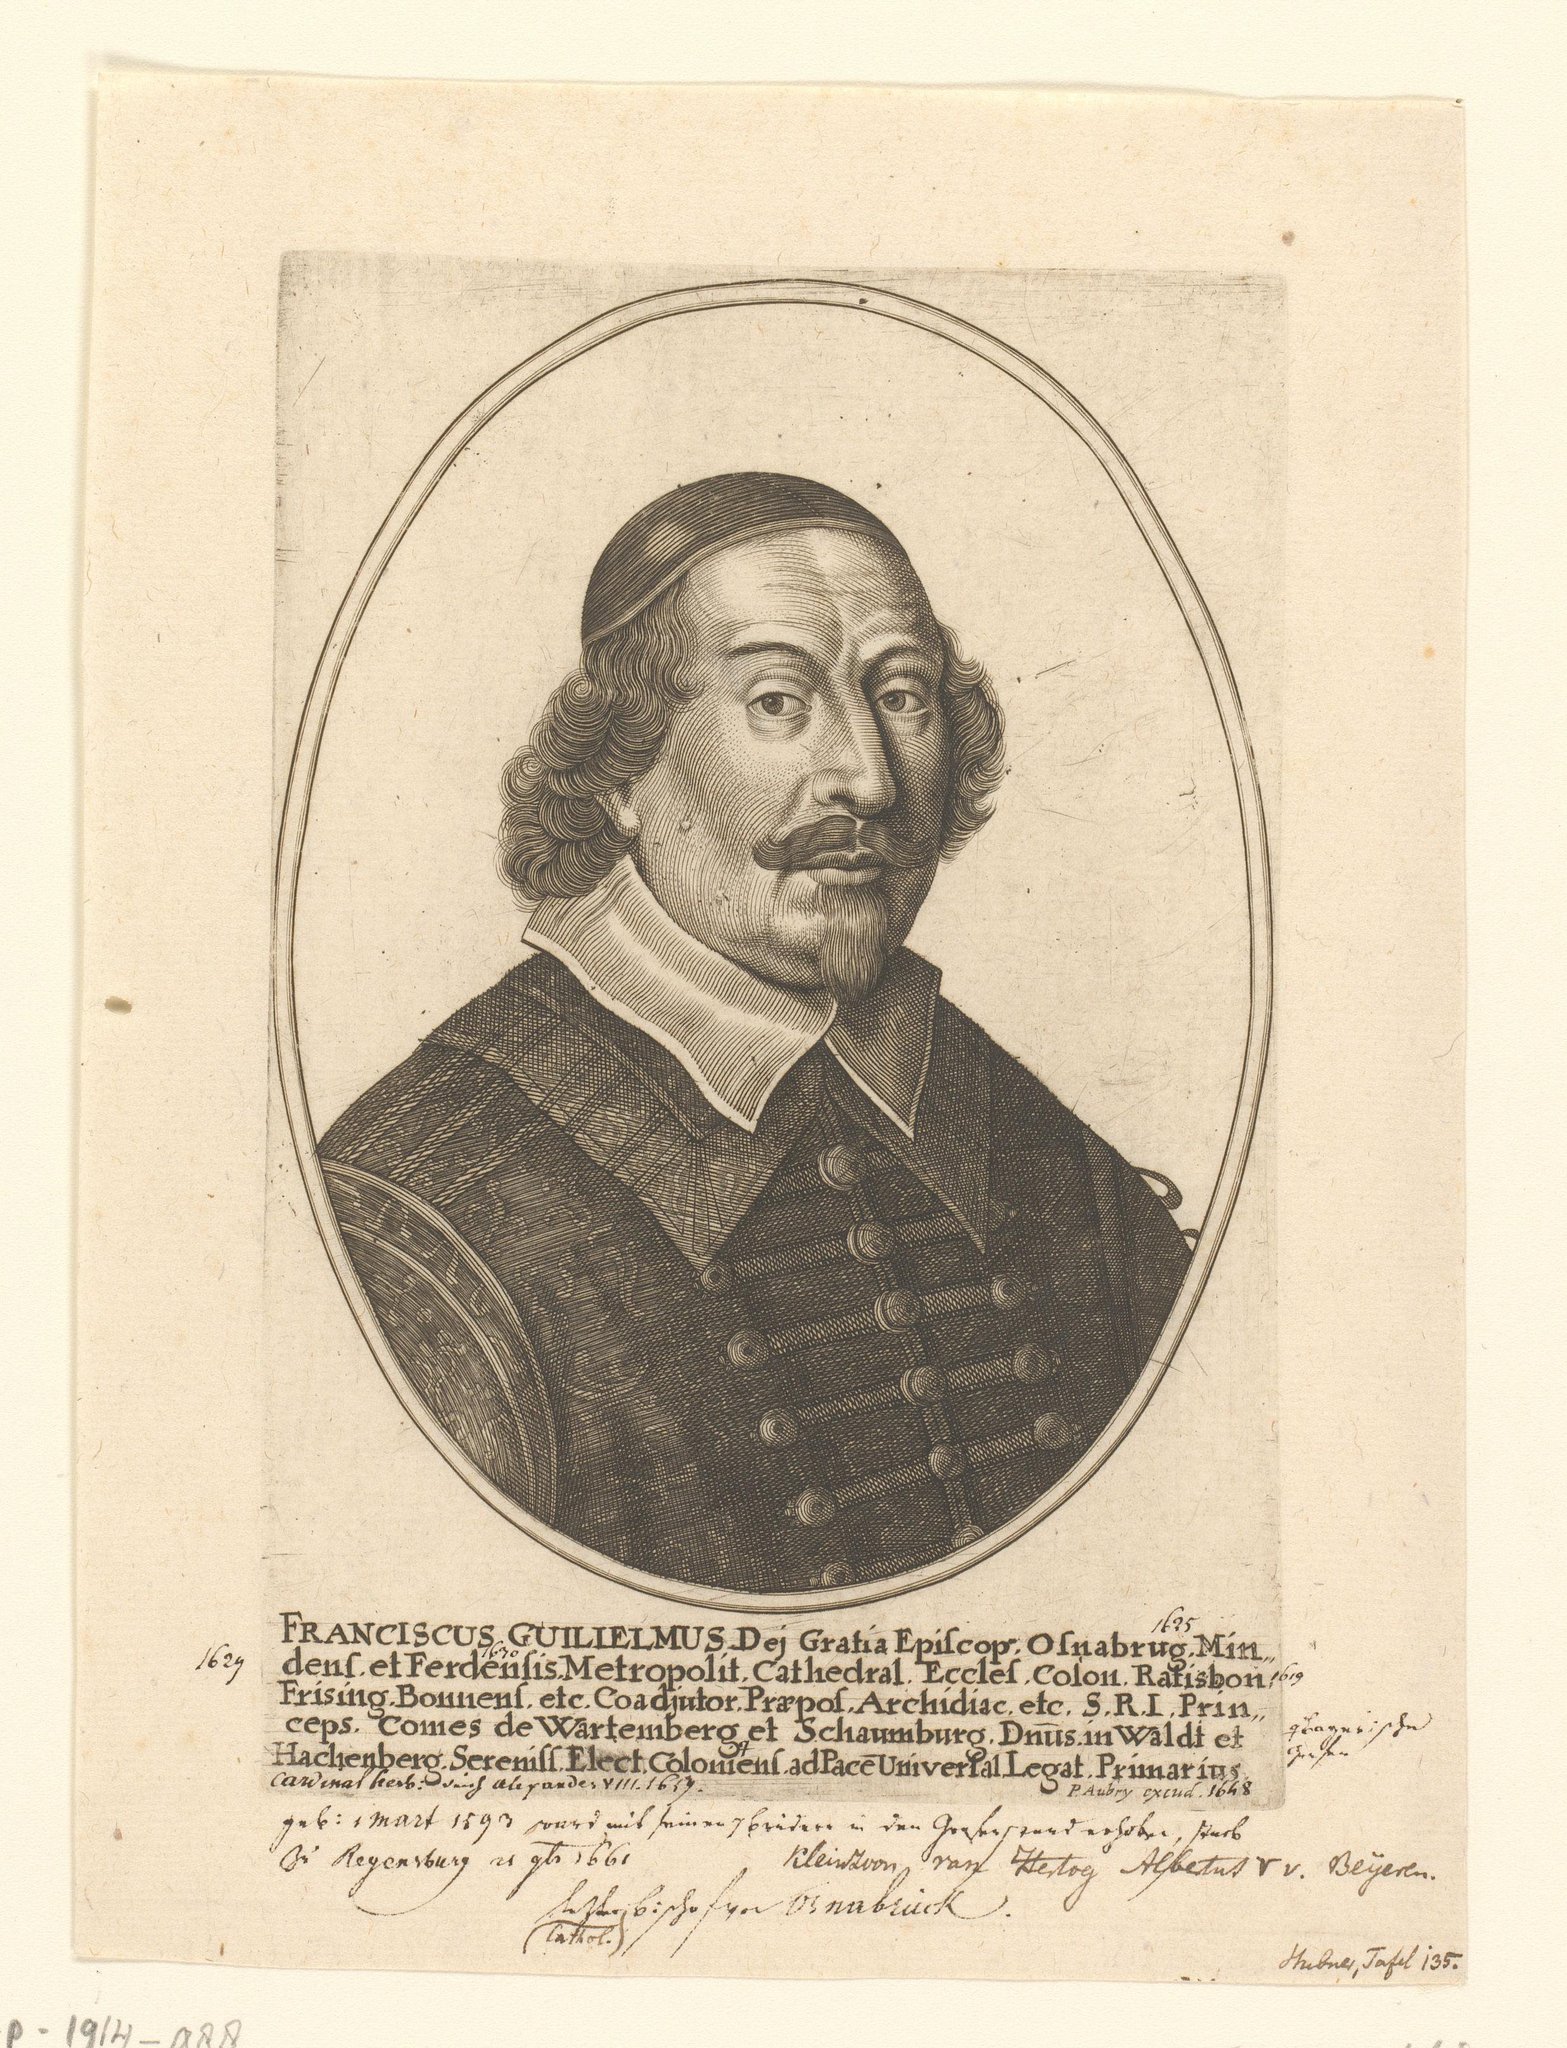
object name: print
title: Portretten van afgevaardigden bij de Vrede van Westfalen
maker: Anonymous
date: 1648-1650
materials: paper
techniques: engraving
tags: priest, cardinal, historical persons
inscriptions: collector's mark: Lugt 2228, inscription: ‘(...)’